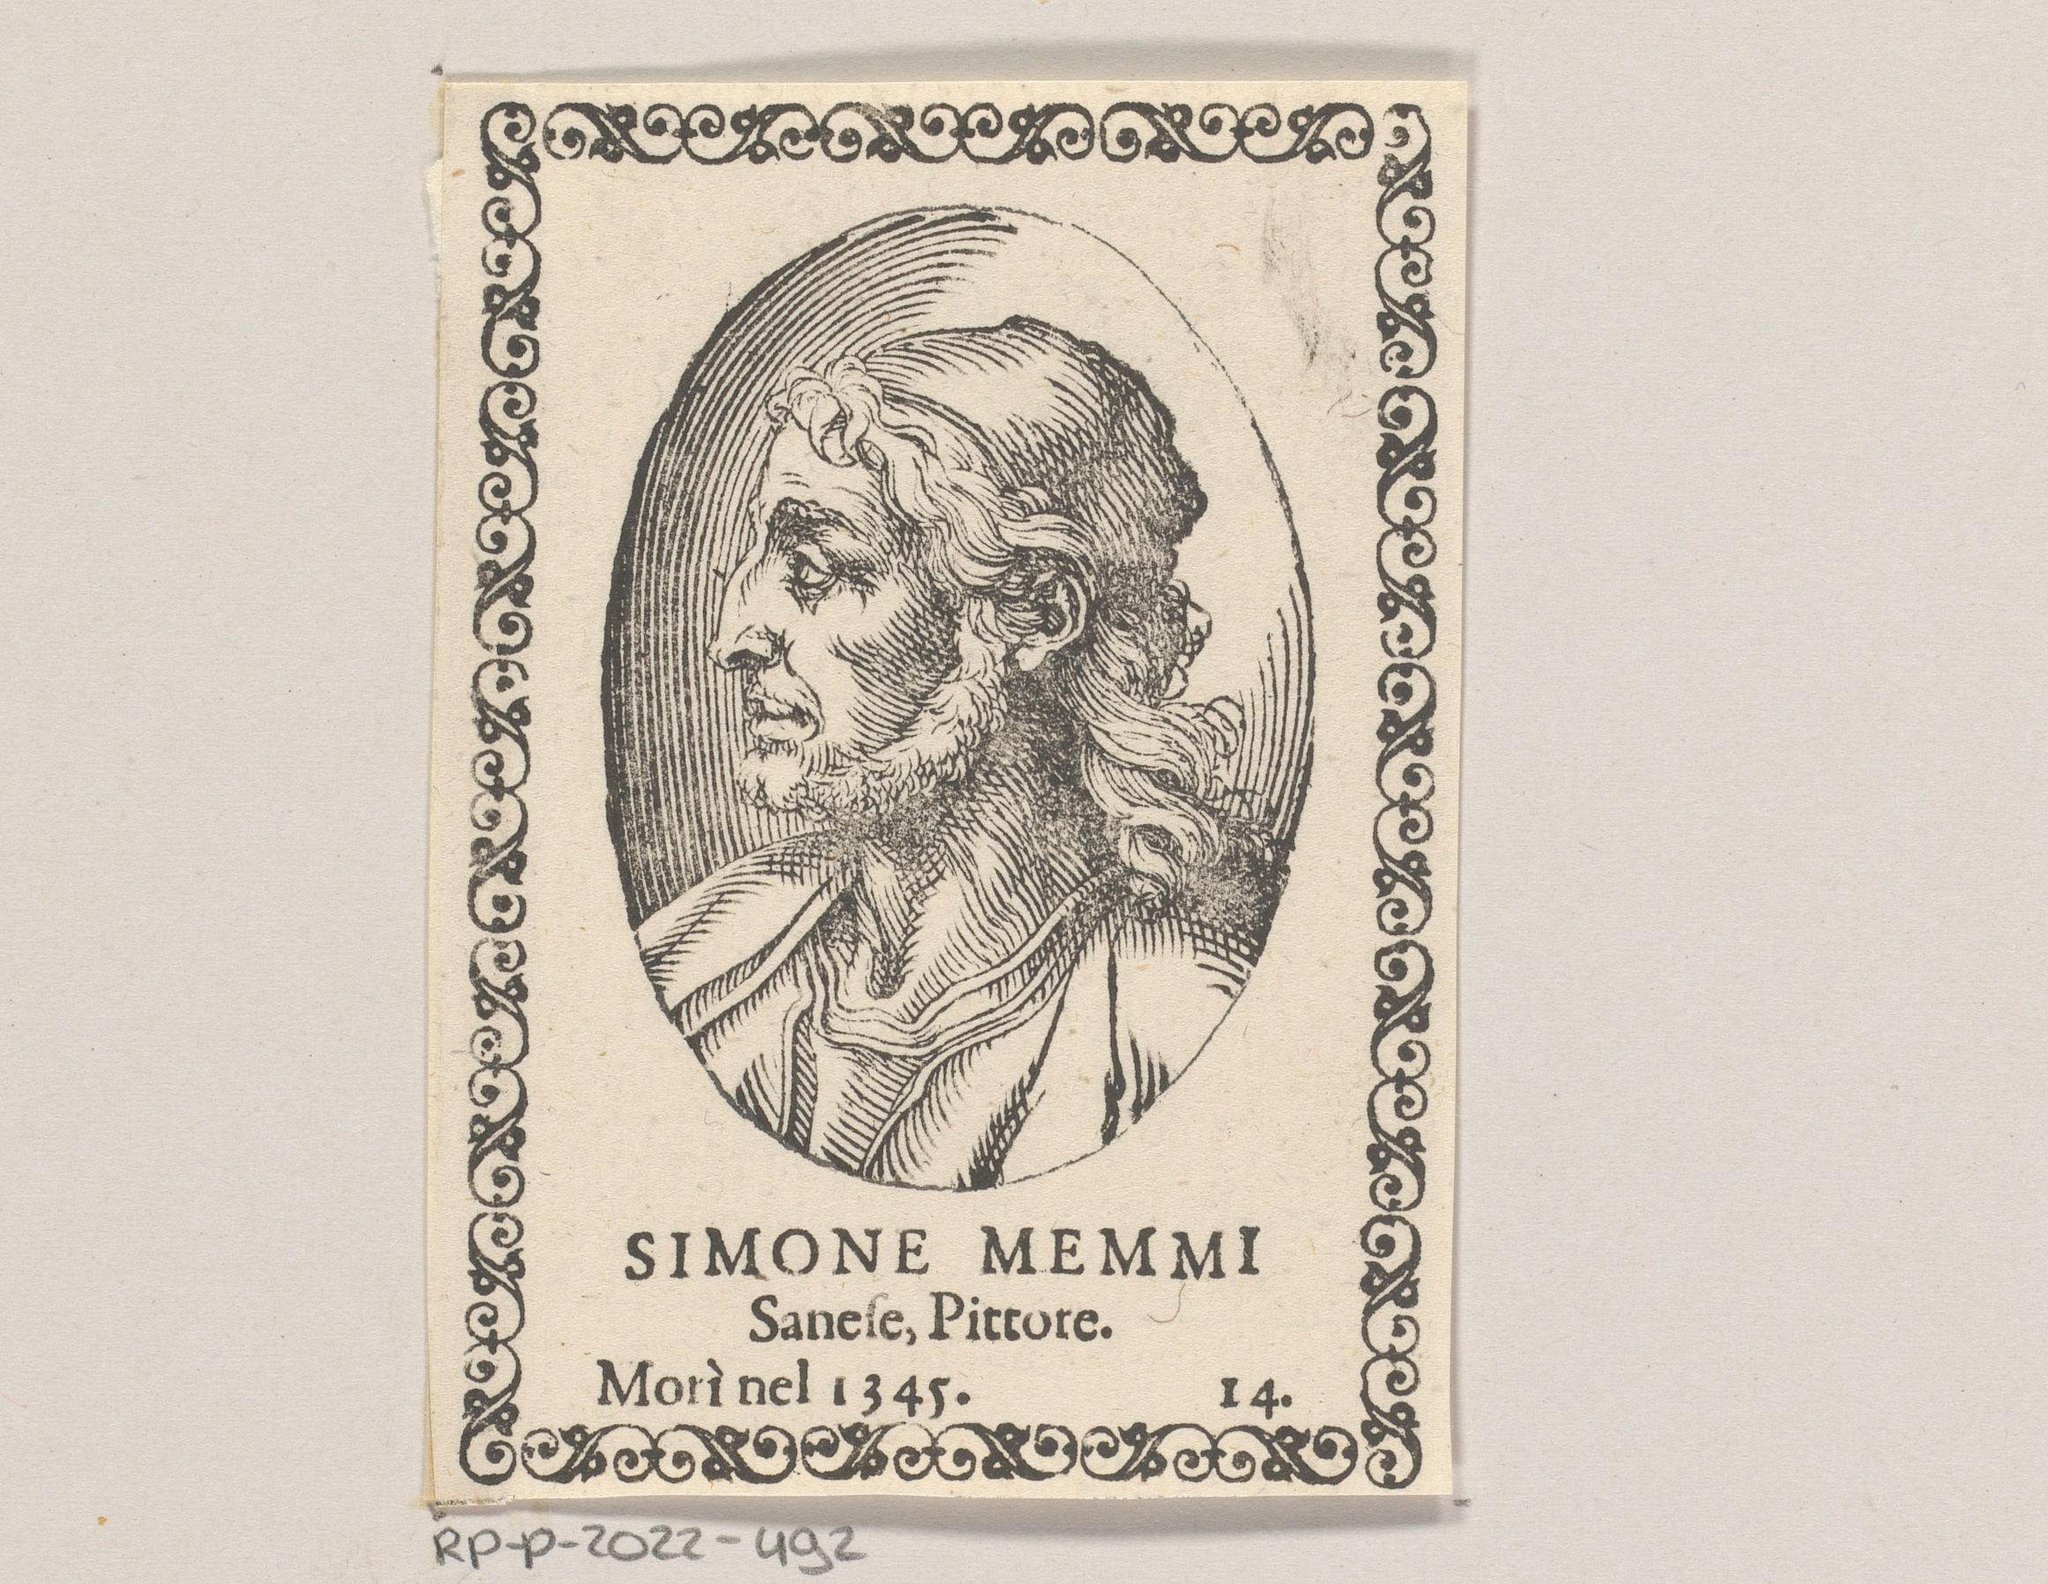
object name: print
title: Portret van Simone Martini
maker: Anonymous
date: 1550-1700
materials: paper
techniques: woodcut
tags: painter, simone martini, historical persons